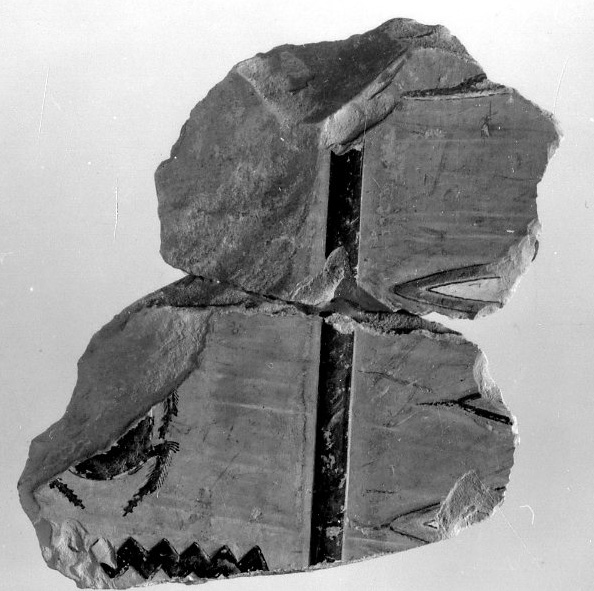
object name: relief fragment, tomb of meketre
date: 1981-1975 BCE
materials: limestone, paint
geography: egypt